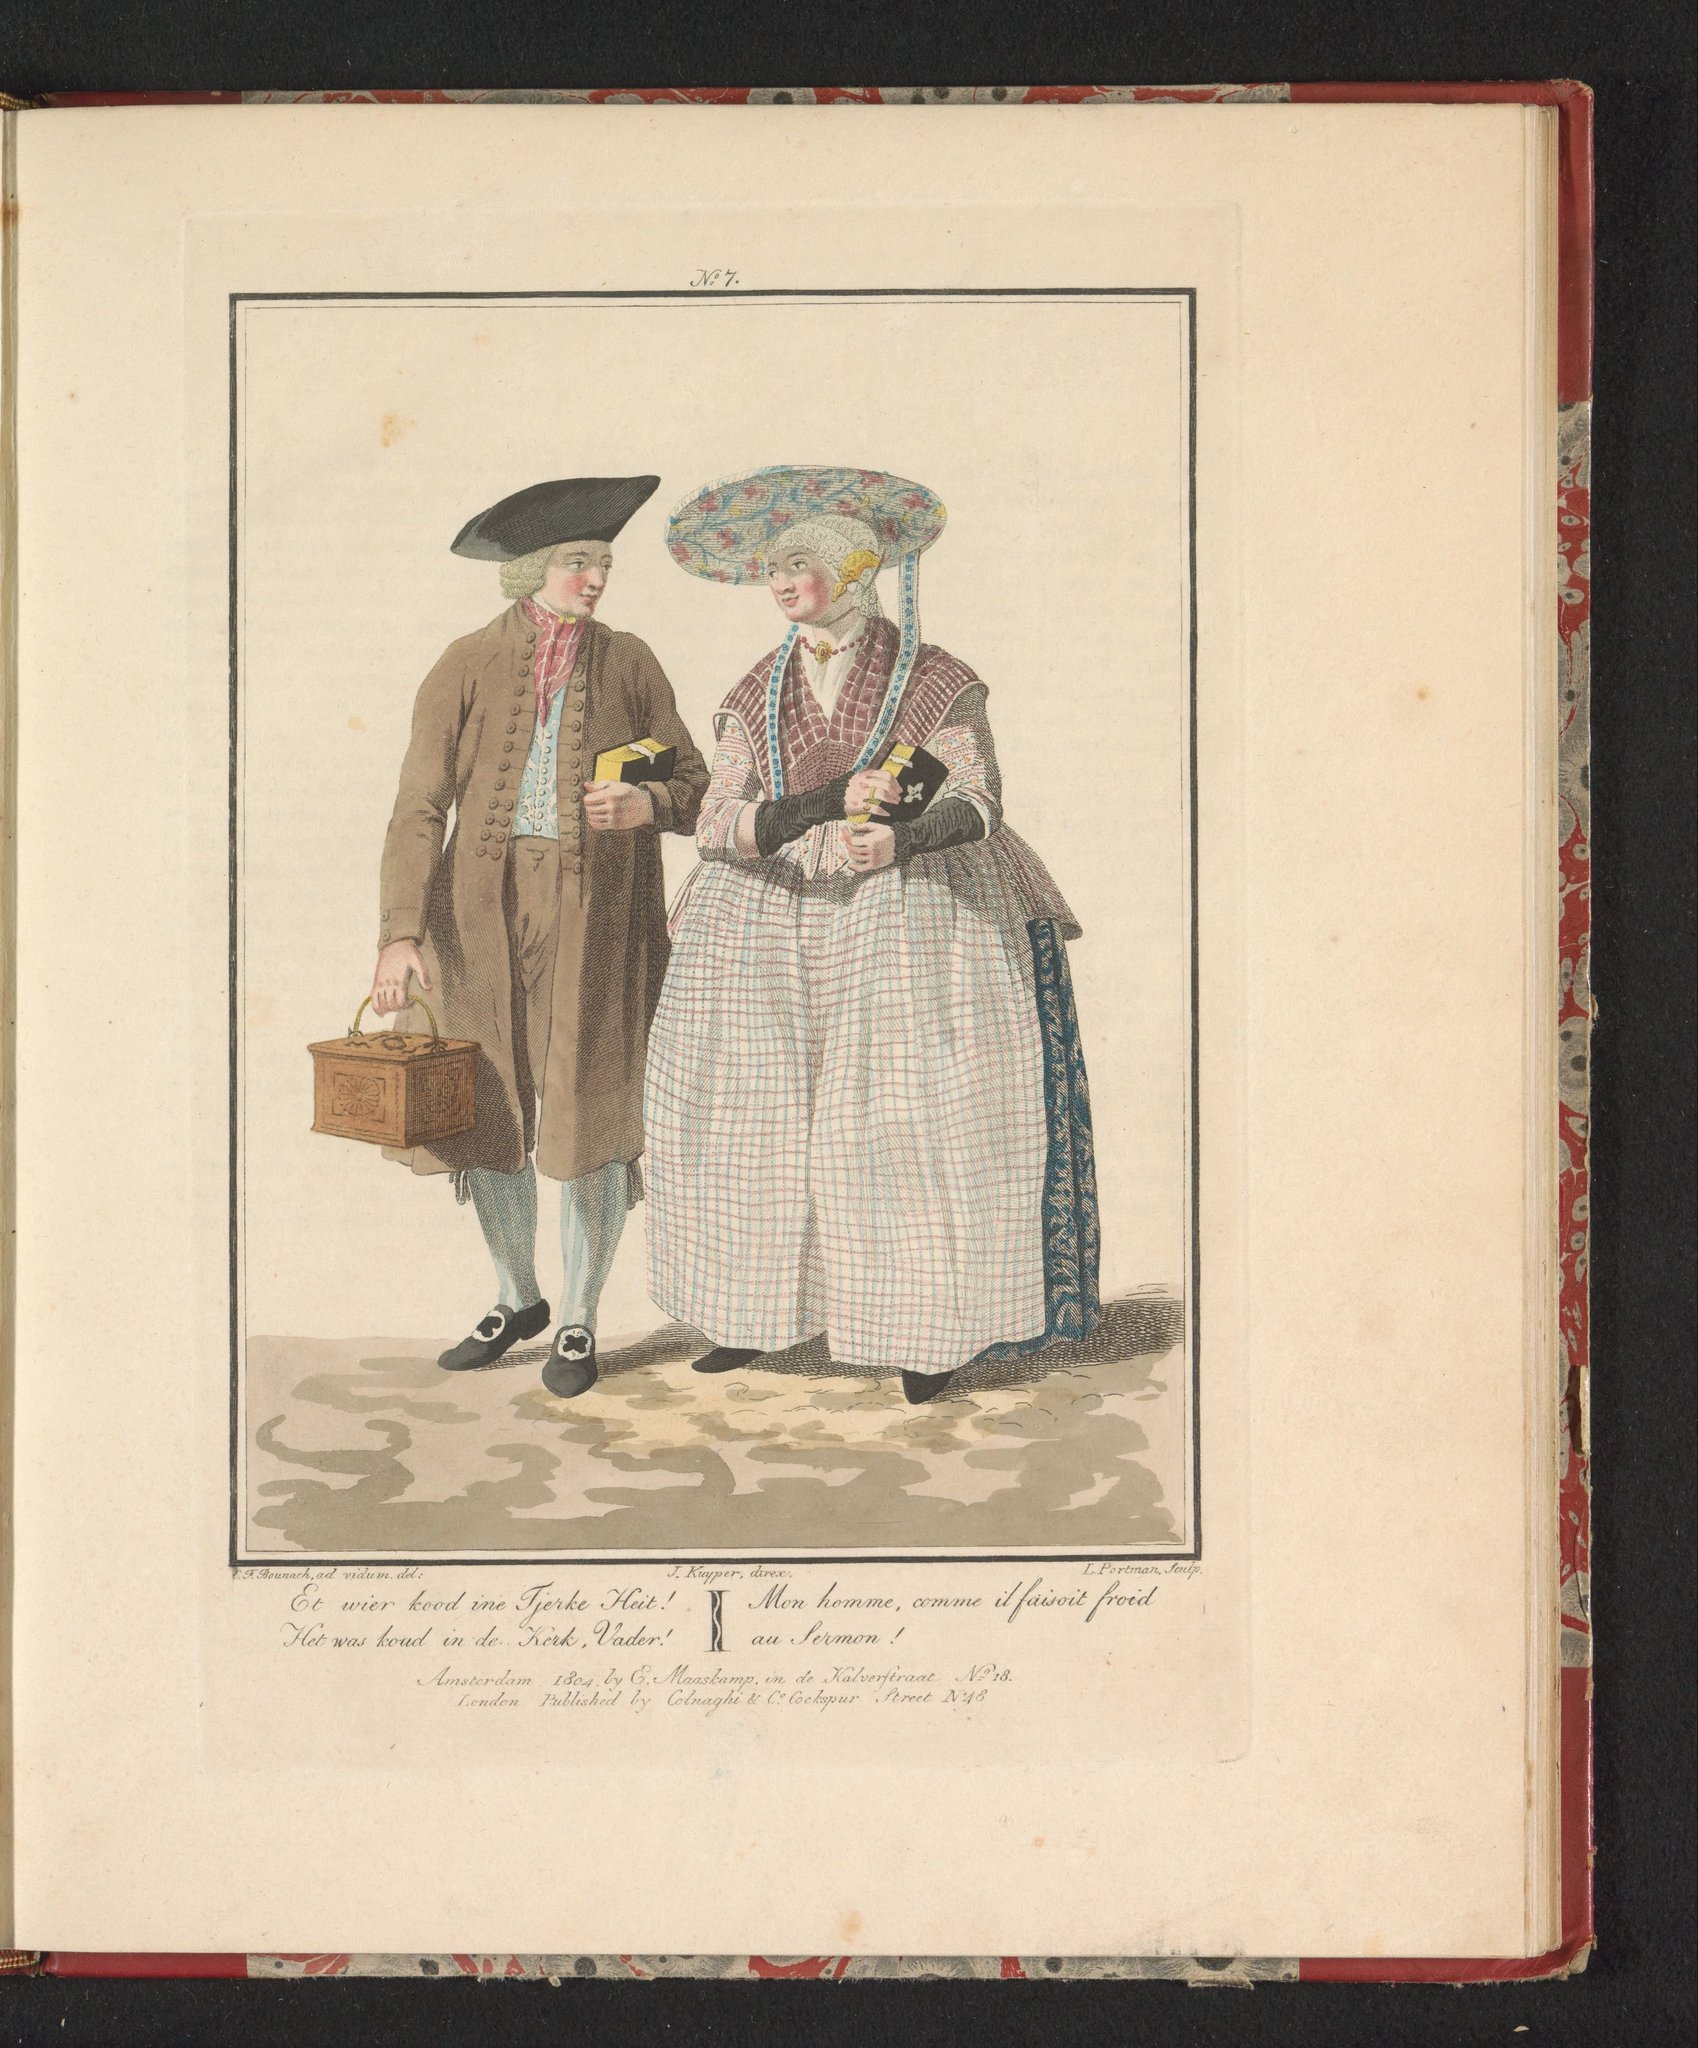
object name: book illustration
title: Et wier kood ine Tjerke Heit ! Het was koud in de Kerk, Vader! / Mon homme, comme il faisoit froid au Sermon!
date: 1804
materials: paper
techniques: etching, hand coloring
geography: london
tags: going to church, folk costume, regional costume, clothes, costume, fisherman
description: Een Friese schippper en zijn vrouw uit de kerk komend met bijbels in de hand. De man draagt ook een stoofje. Tweede aflevering van vier platen, verschenen in 1804. Onderdeel van een gebonden uitgave van de reeks van twintig platen van Nederlandse klederdrachten in de Bataafse Republiek aan het begin van de negentiende eeuw door Maaskamp, ca. 1807.